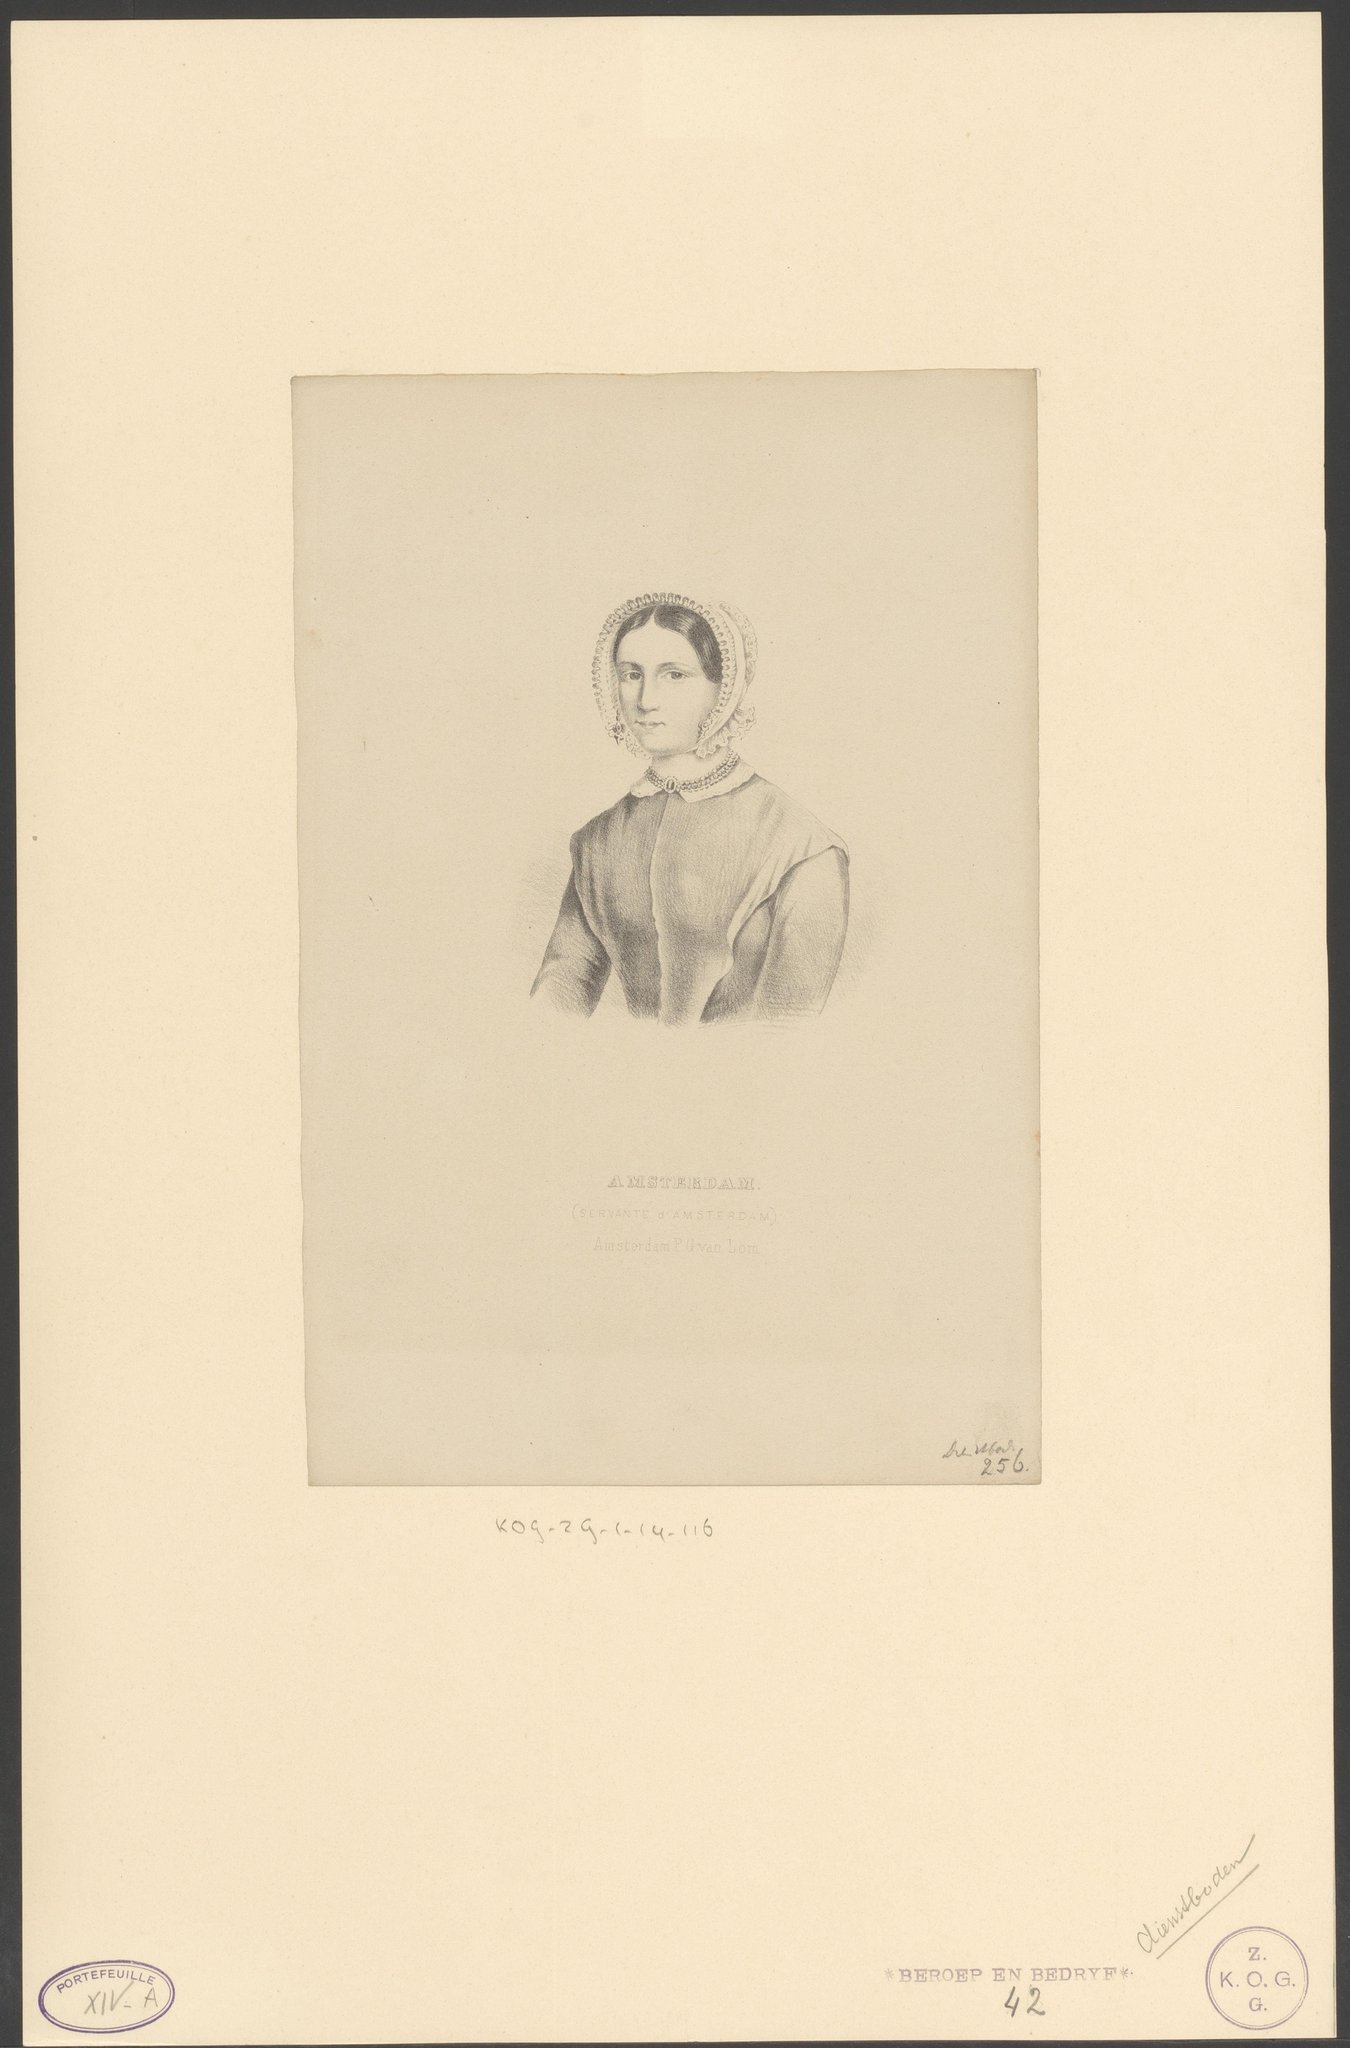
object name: print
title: Amsterdamse dienstbode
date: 1830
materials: paper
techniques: lithograph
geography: amsterdam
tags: maid ~ house personnel, amsterdam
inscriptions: collector's mark, collector's mark: Lugt 1641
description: Een dienstbode van voren ten halve lijve met een geplooid mutsje, een kanten kraagje, oorbellen en een ketting. Onderwerpsrubrieken binnen de Atlas Zeden en Gewoonten: Beroep en bedrijf. Vrouwelijk beroep en bedrijf. Dienstboden.